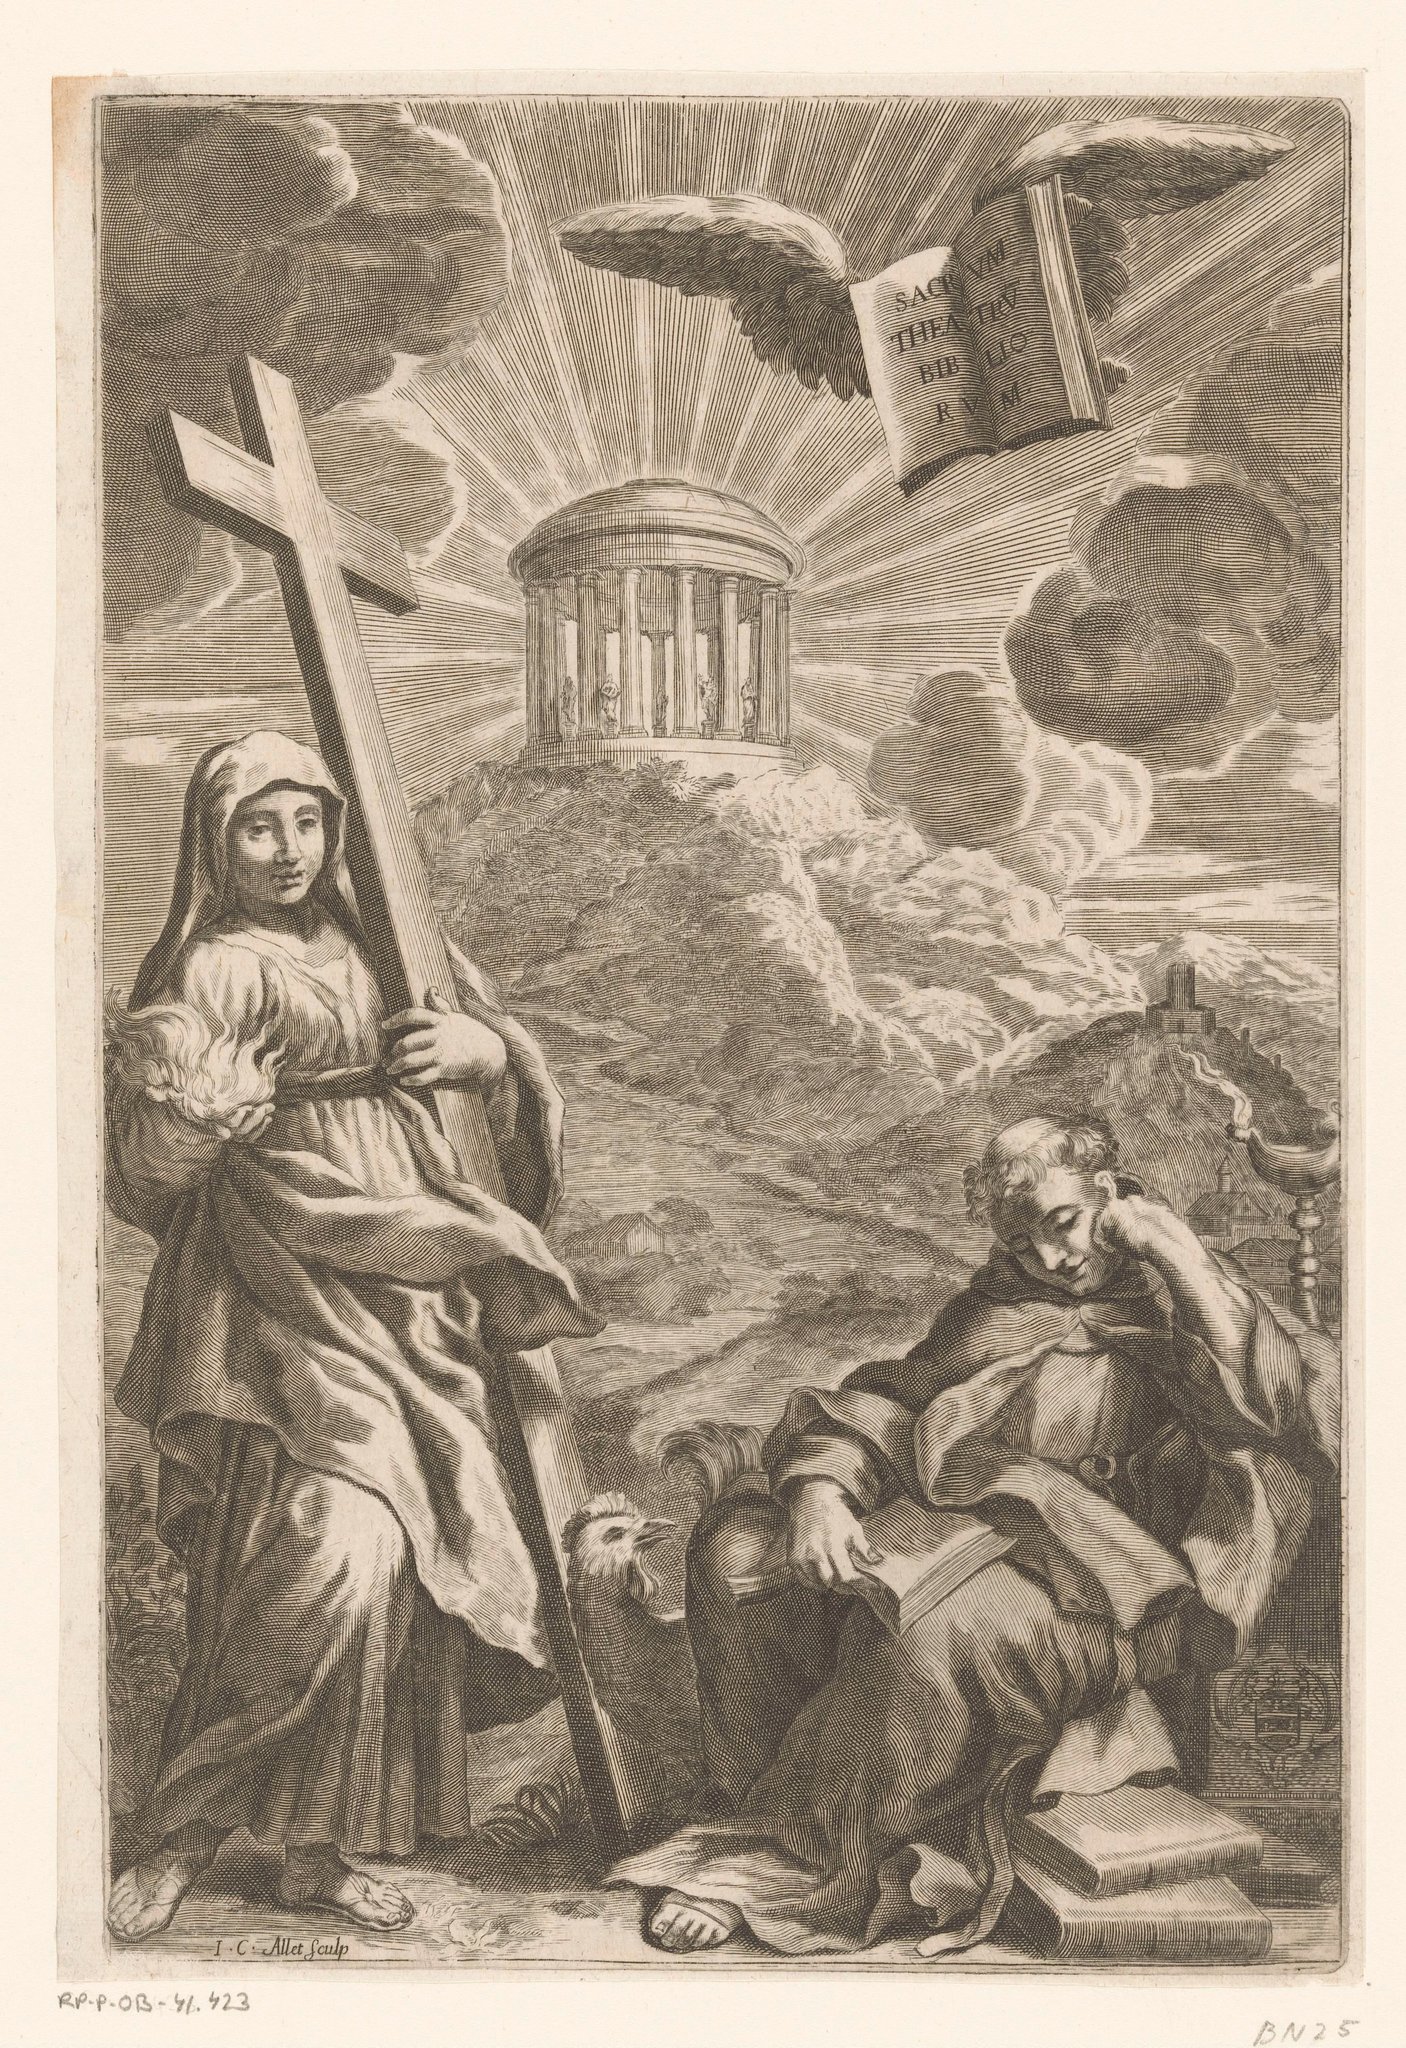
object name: titelblad, titelpagina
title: Titelpagina voor: Lorenzo di Santa Francesca, Sacrum Theatrum Bibliorum (...), 1690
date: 1690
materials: paper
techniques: engraving, etching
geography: italy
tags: sitting figure, reading, cross as symbol of christ, book, temple, shrine ~ roman religion, model, mannequin, female saints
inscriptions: collector's mark: Lugt 2228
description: Titelpagina voor: Santa Francesca, Lorenzo di. Sacrum Theatrum Bibliorum in quo exponuntur commentaria litteralia et moralia (...). Venetië: Antonio Tivani, 1690.